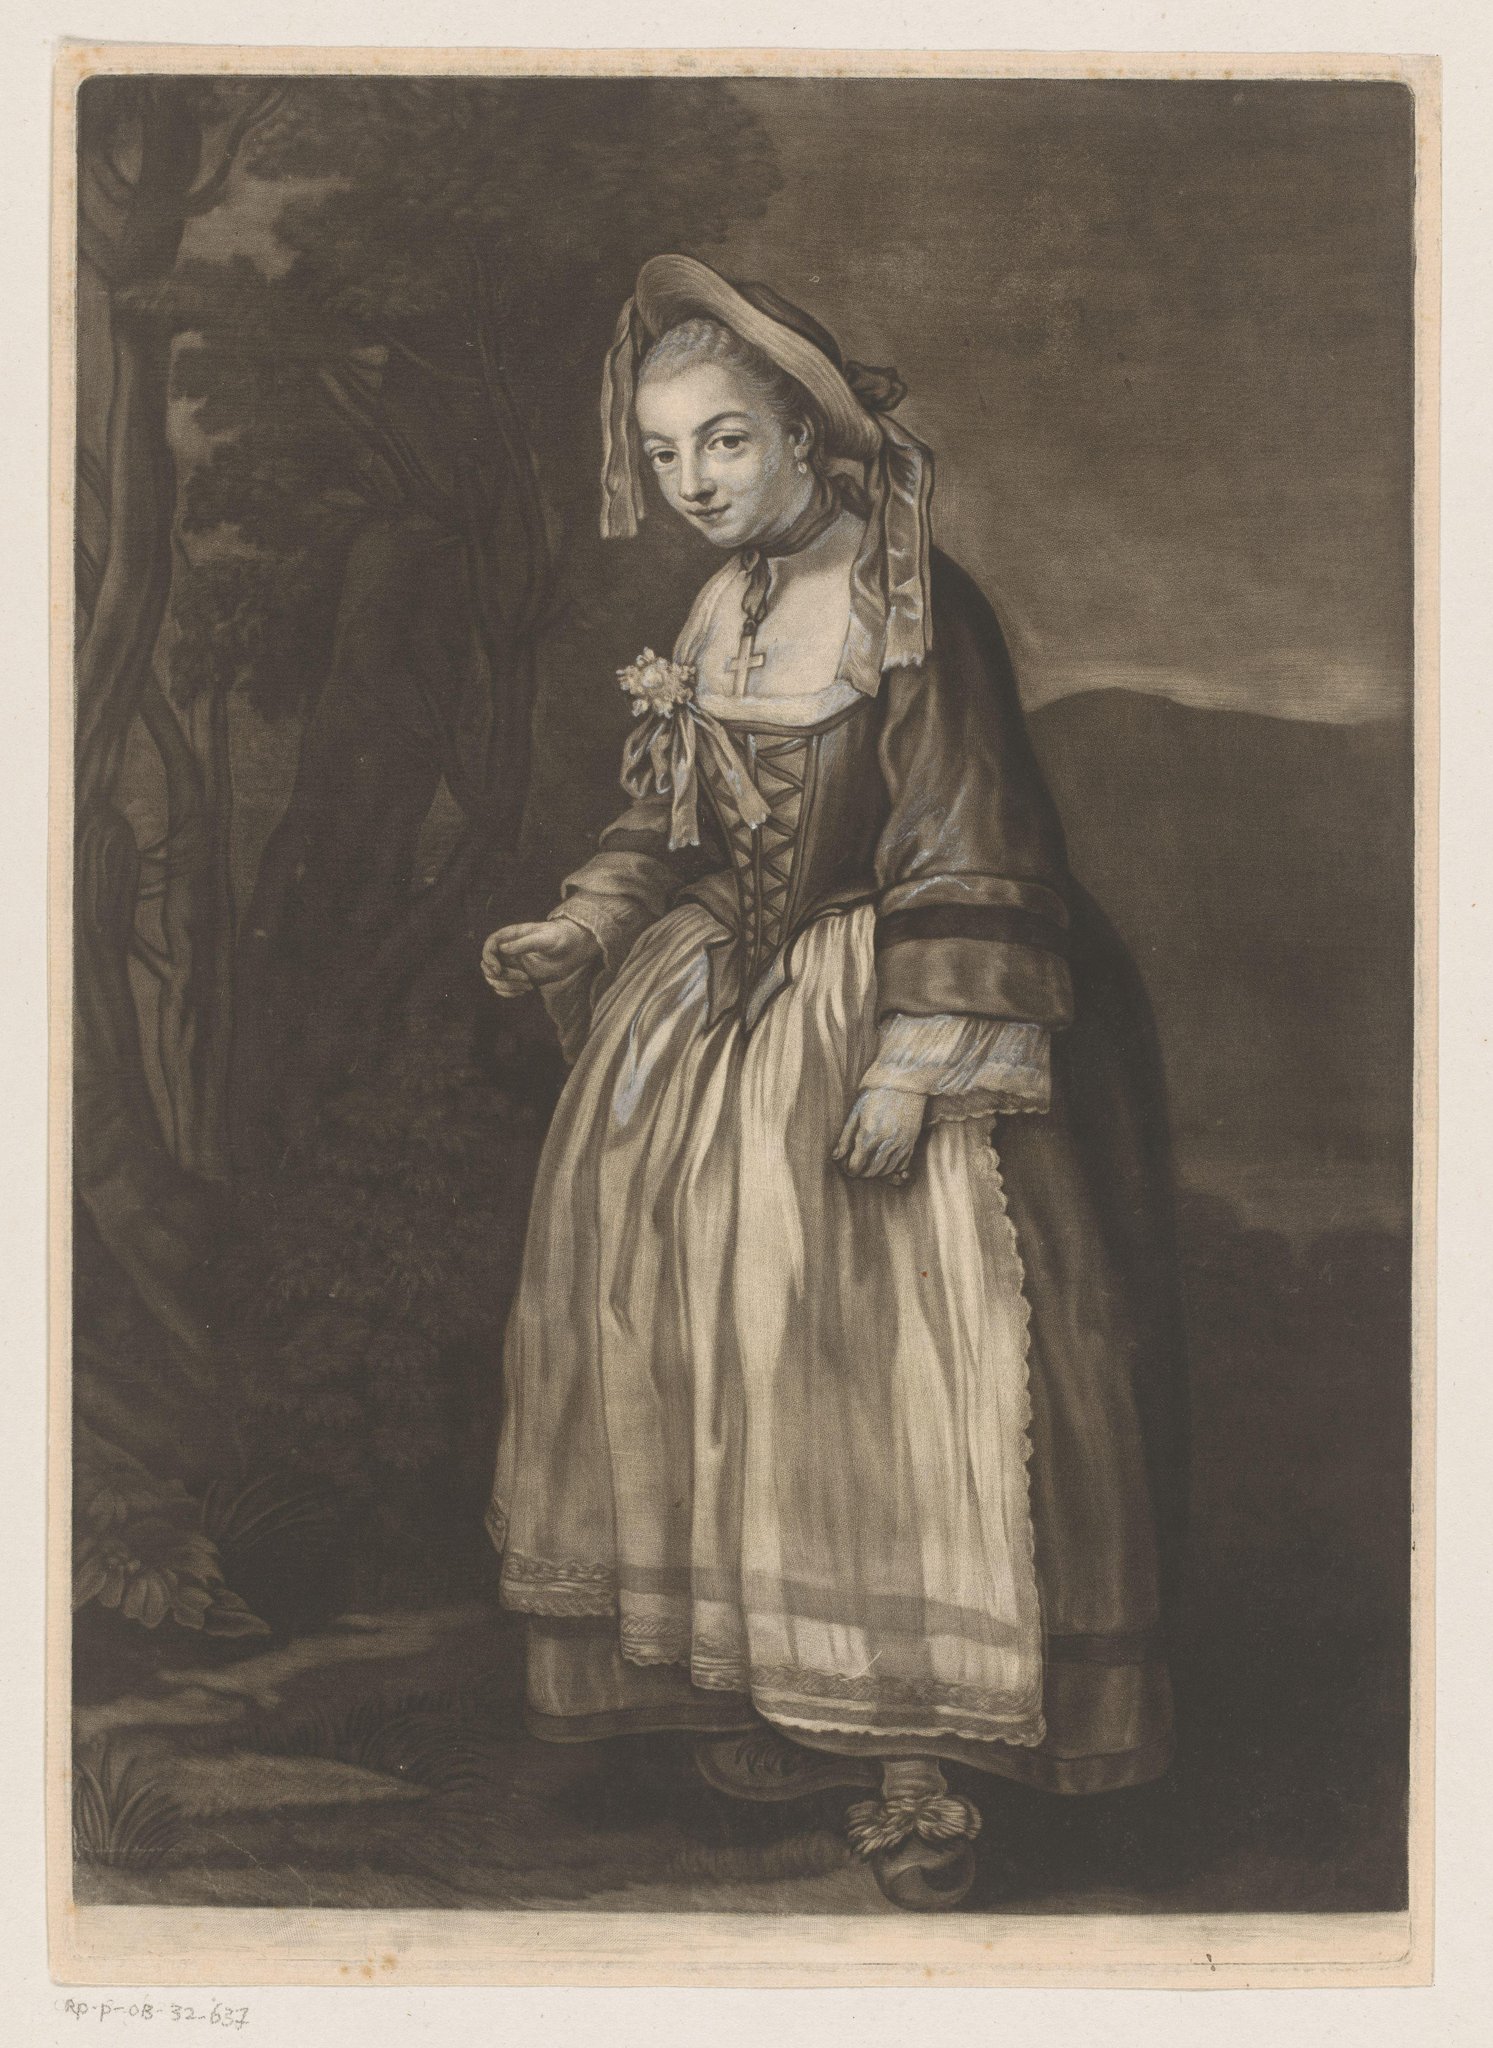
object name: print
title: Portret van een actrice bekend als mevrouw Favart in de rol van Spilletta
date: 1746-1766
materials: paint, paper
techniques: brush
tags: historical persons, actress (on the stage)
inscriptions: collector's mark: Lugt 240